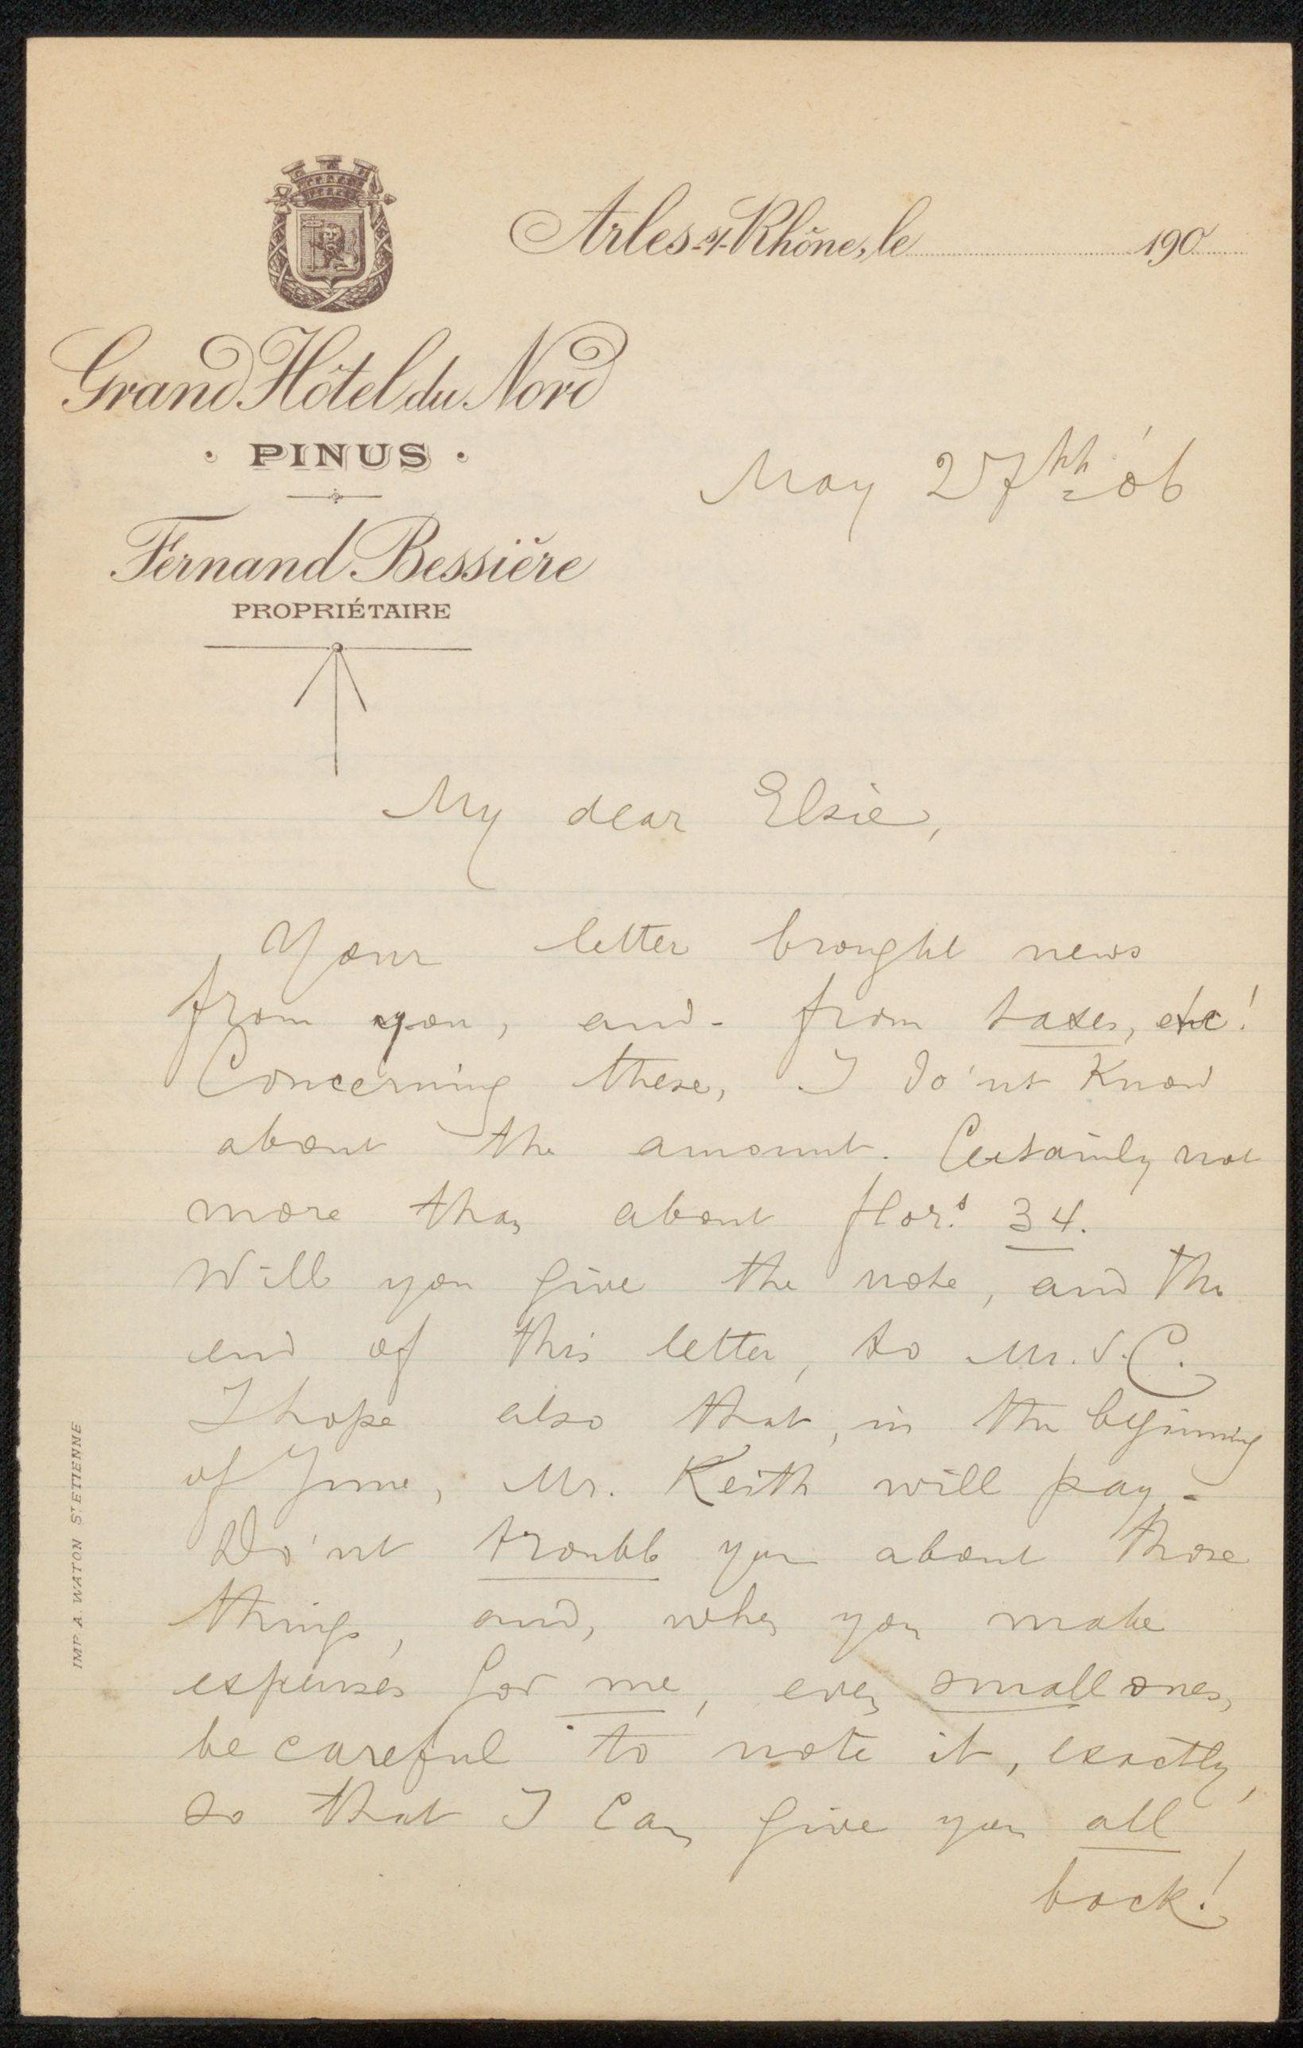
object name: letter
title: Brief aan Elsie Maud Cownie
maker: philip zilcken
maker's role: draughtsman, painter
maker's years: 1857-1930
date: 1906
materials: ink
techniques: pen, printing, writing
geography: arles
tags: amsterdam, the hague, painter, print maker, draughtsman, isaac israels, renée hélène laure zilcken, frédéric mistral, manchester, elsie maud cownie, travelling; tourism, painting (including book-illumination, miniature-painting), money, printed matter, brussels, marseille, vienna